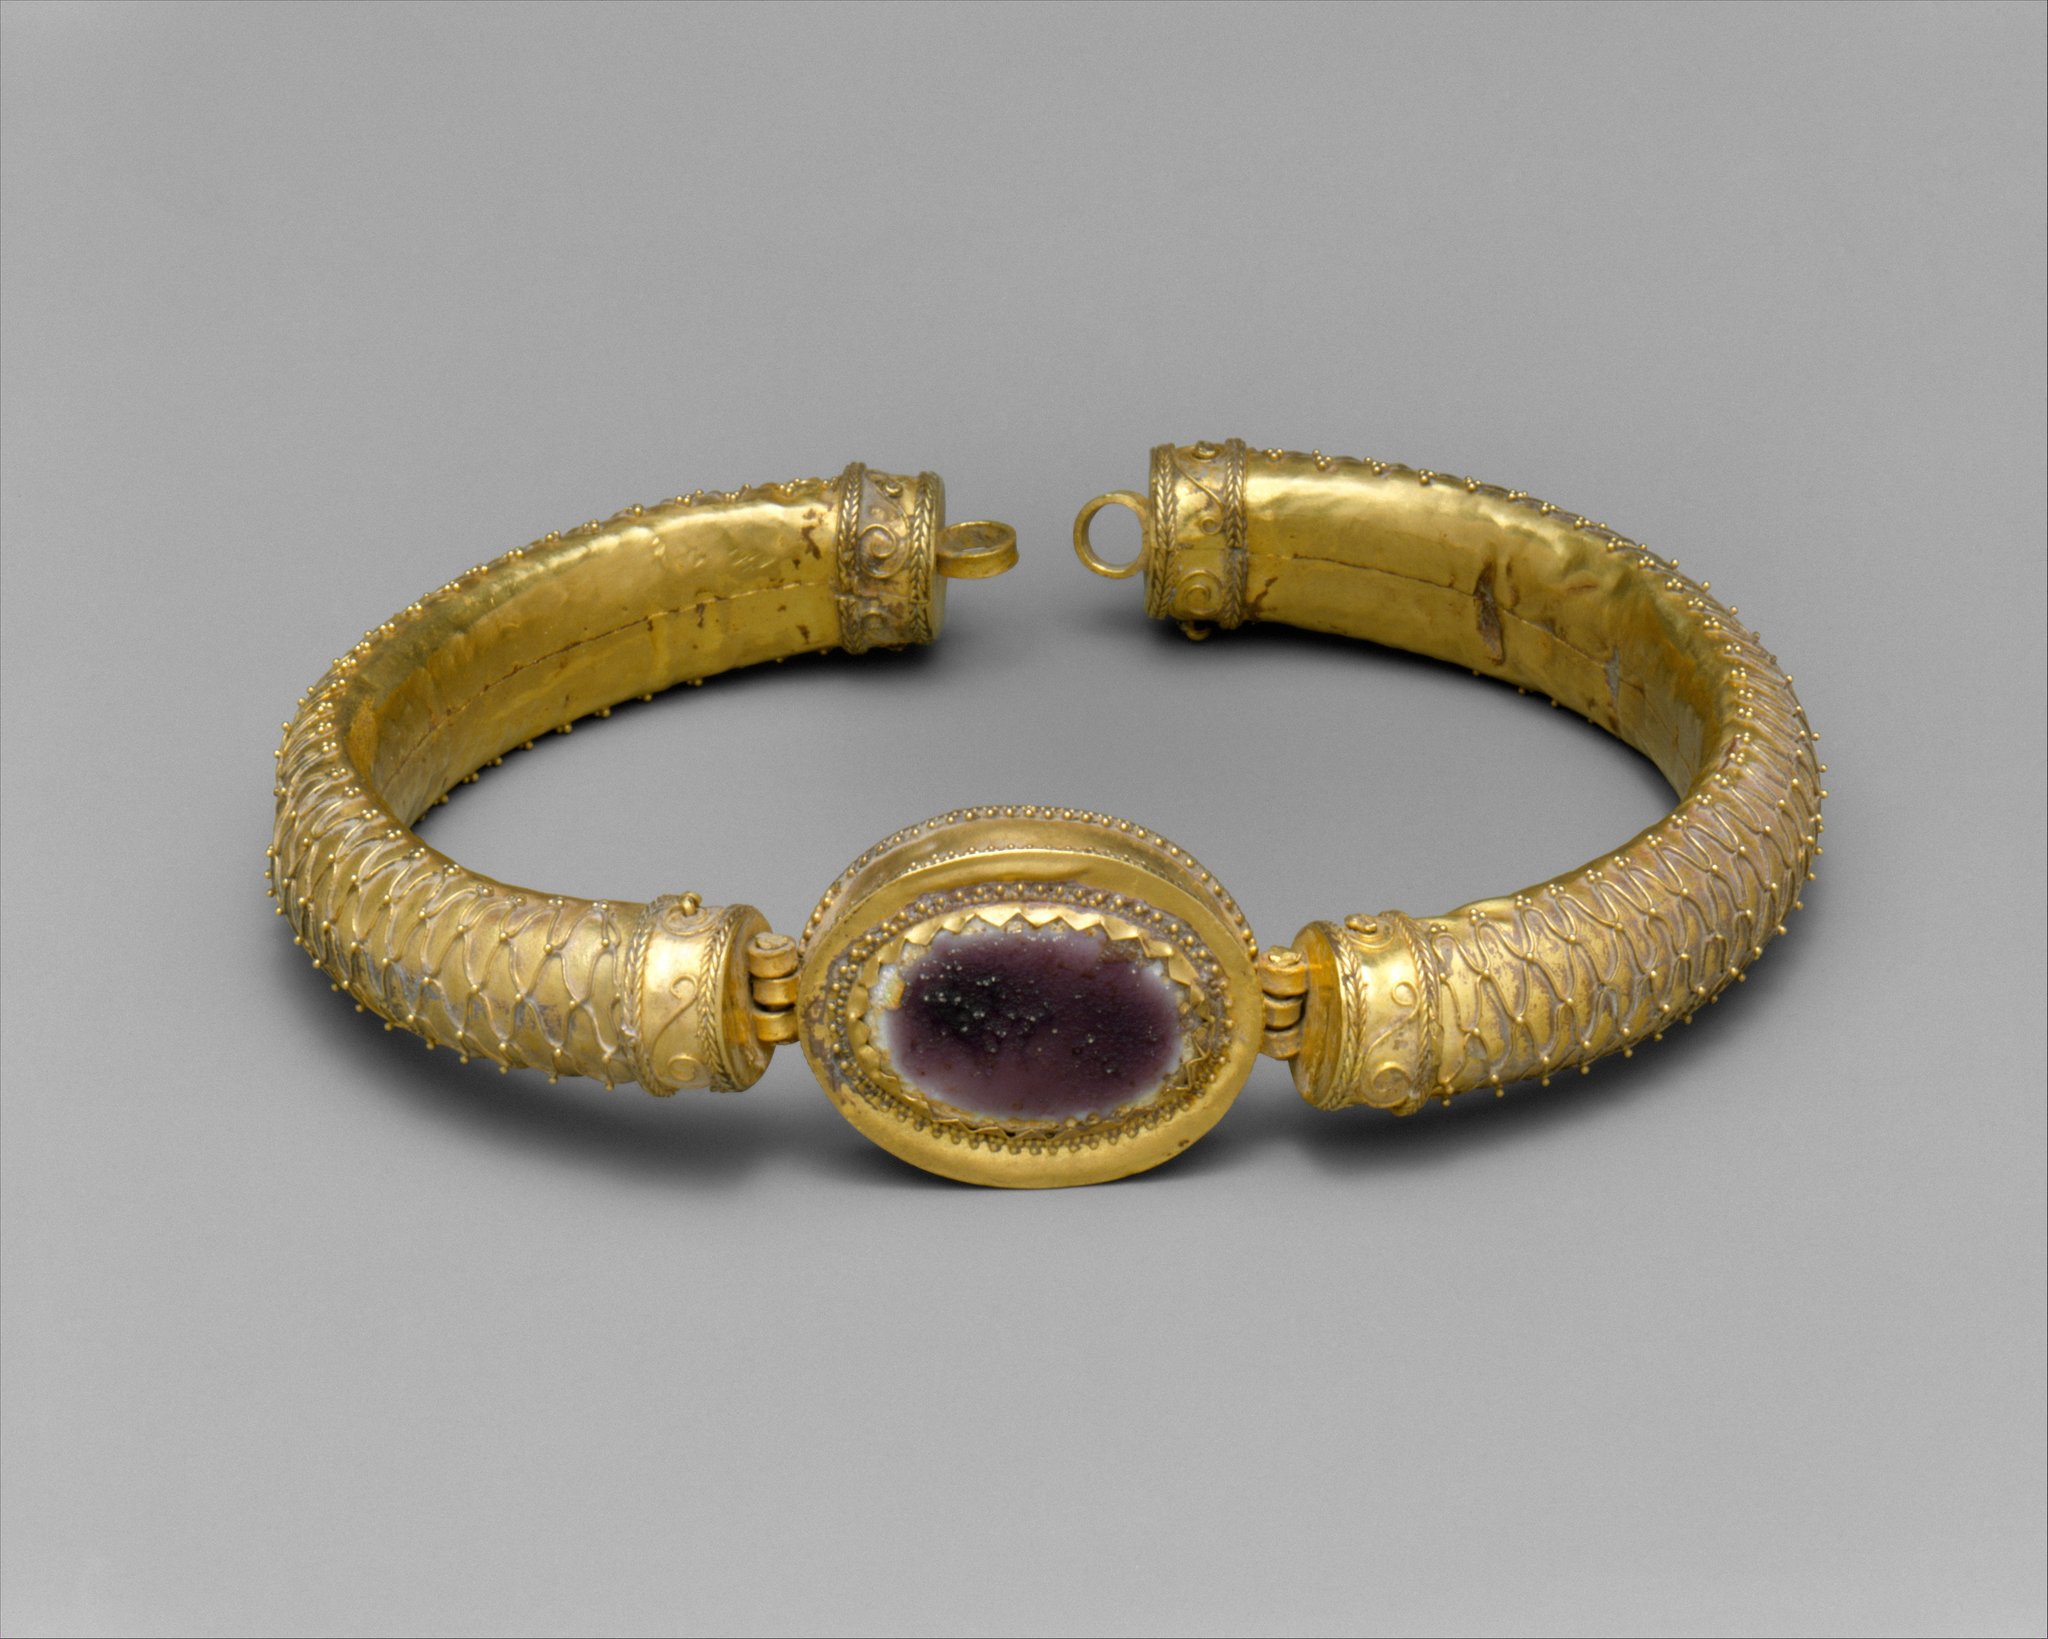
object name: bracelet with central medallion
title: Gold and glass bracelet with central medallion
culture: greek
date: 200-101 BCE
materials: glass, gold